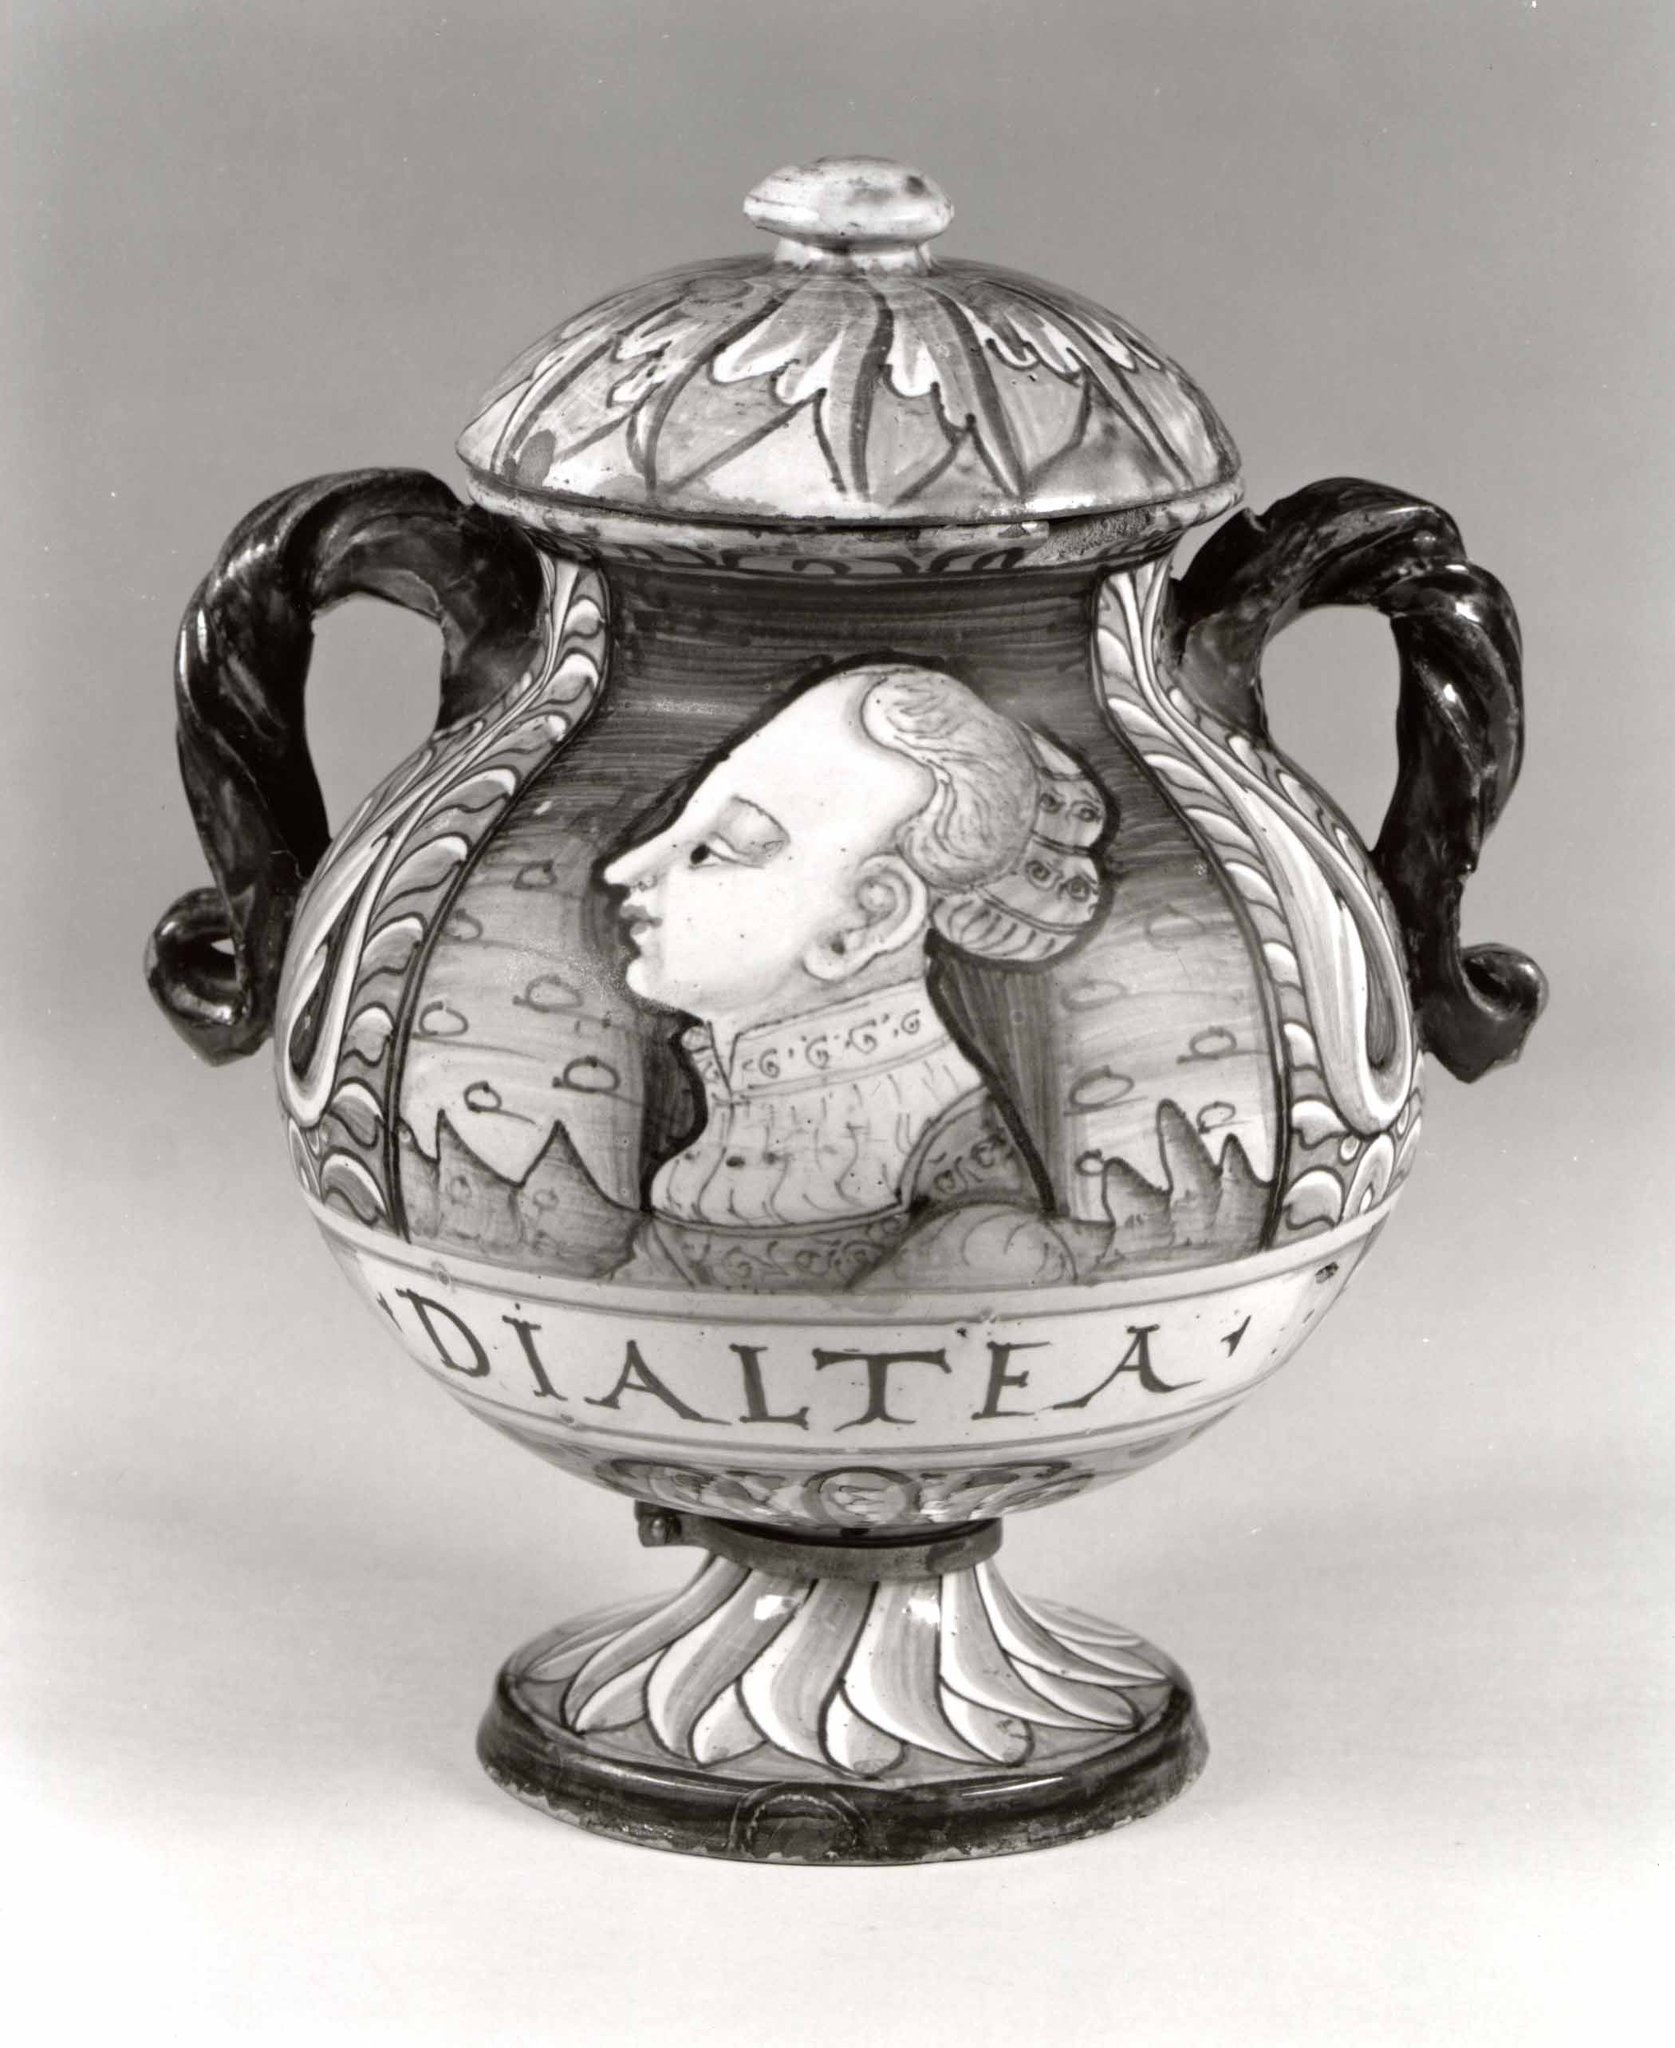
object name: apothecary vase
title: Apothecary vase (vaso da farmacia)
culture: italian, castelli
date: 1530-1540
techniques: maiolica, glazing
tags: women